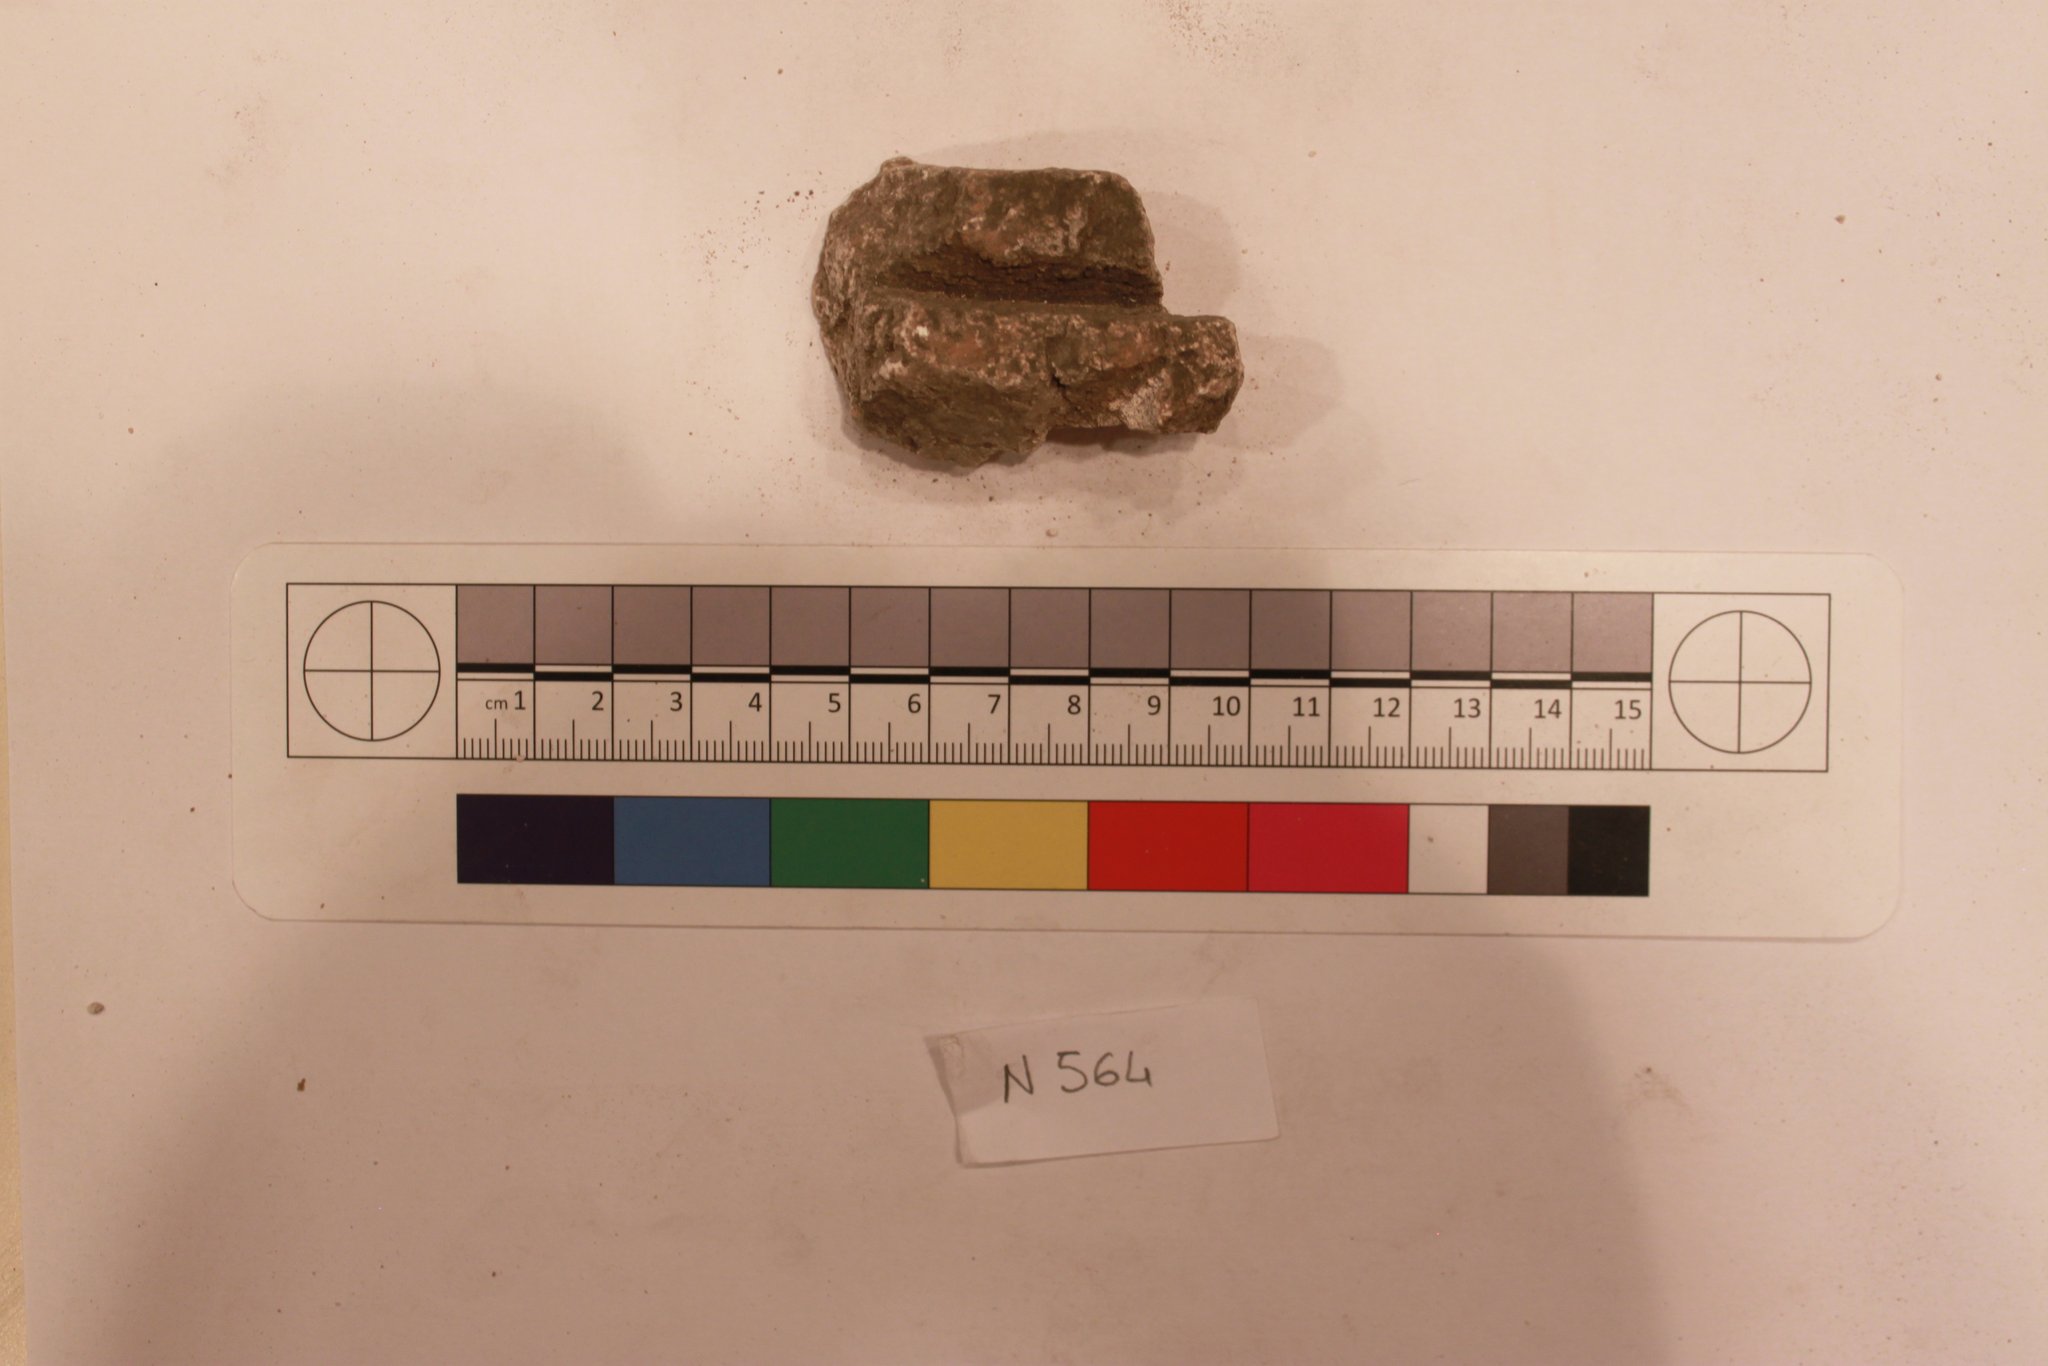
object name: fragment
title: Stucco Fragment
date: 701-1200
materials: plaster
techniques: carving, painting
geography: iran